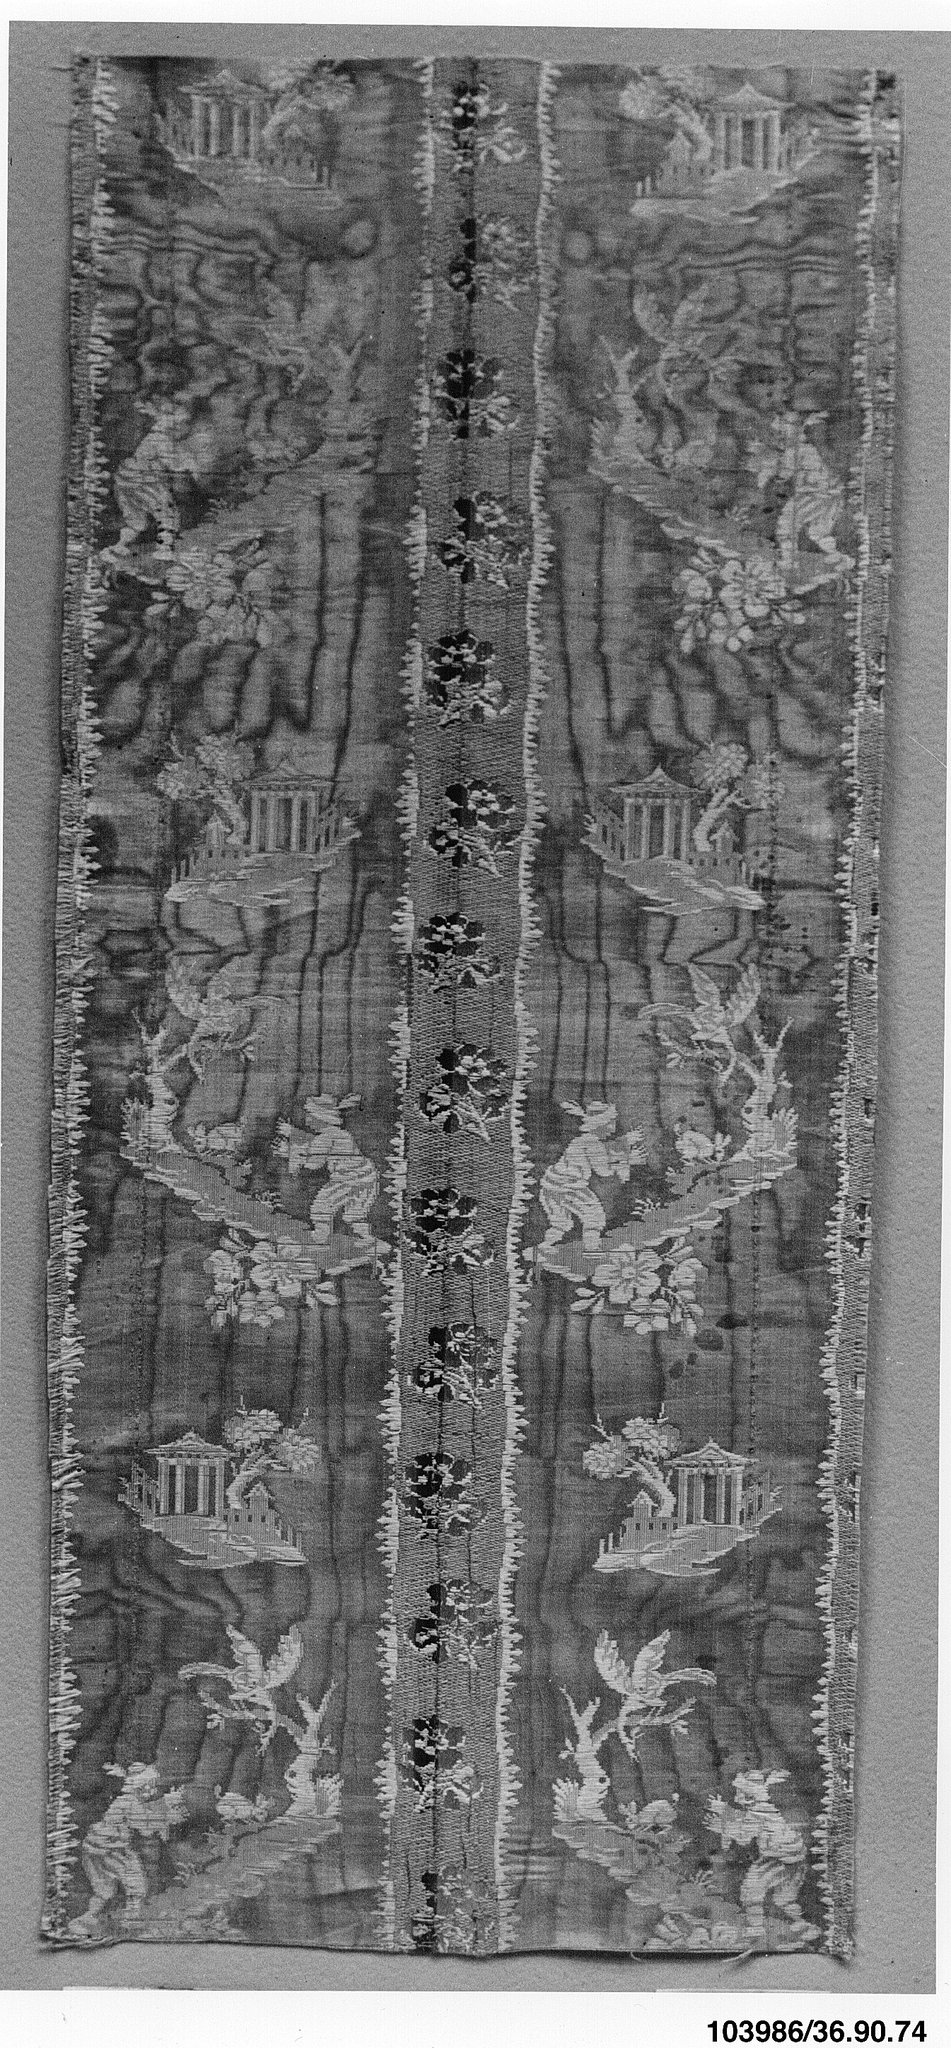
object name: piece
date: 1765-1770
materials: silk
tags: human figures,birds,trees